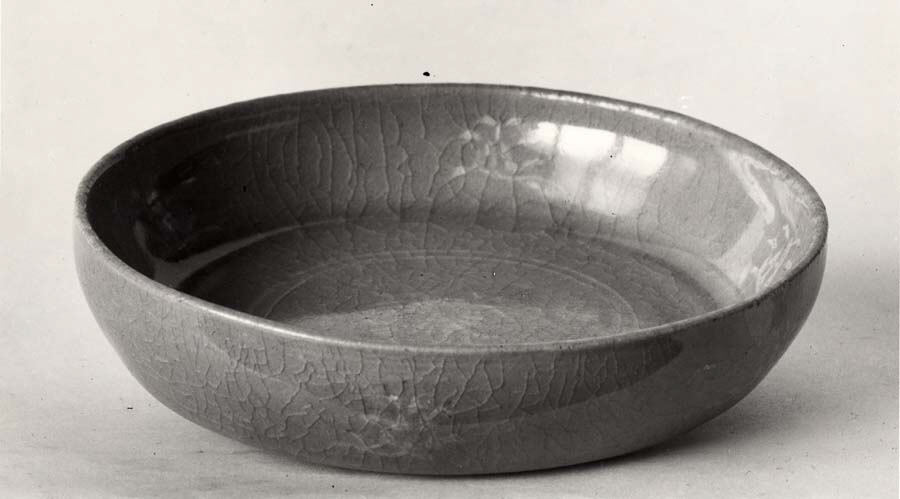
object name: saucer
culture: korean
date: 1150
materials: clay